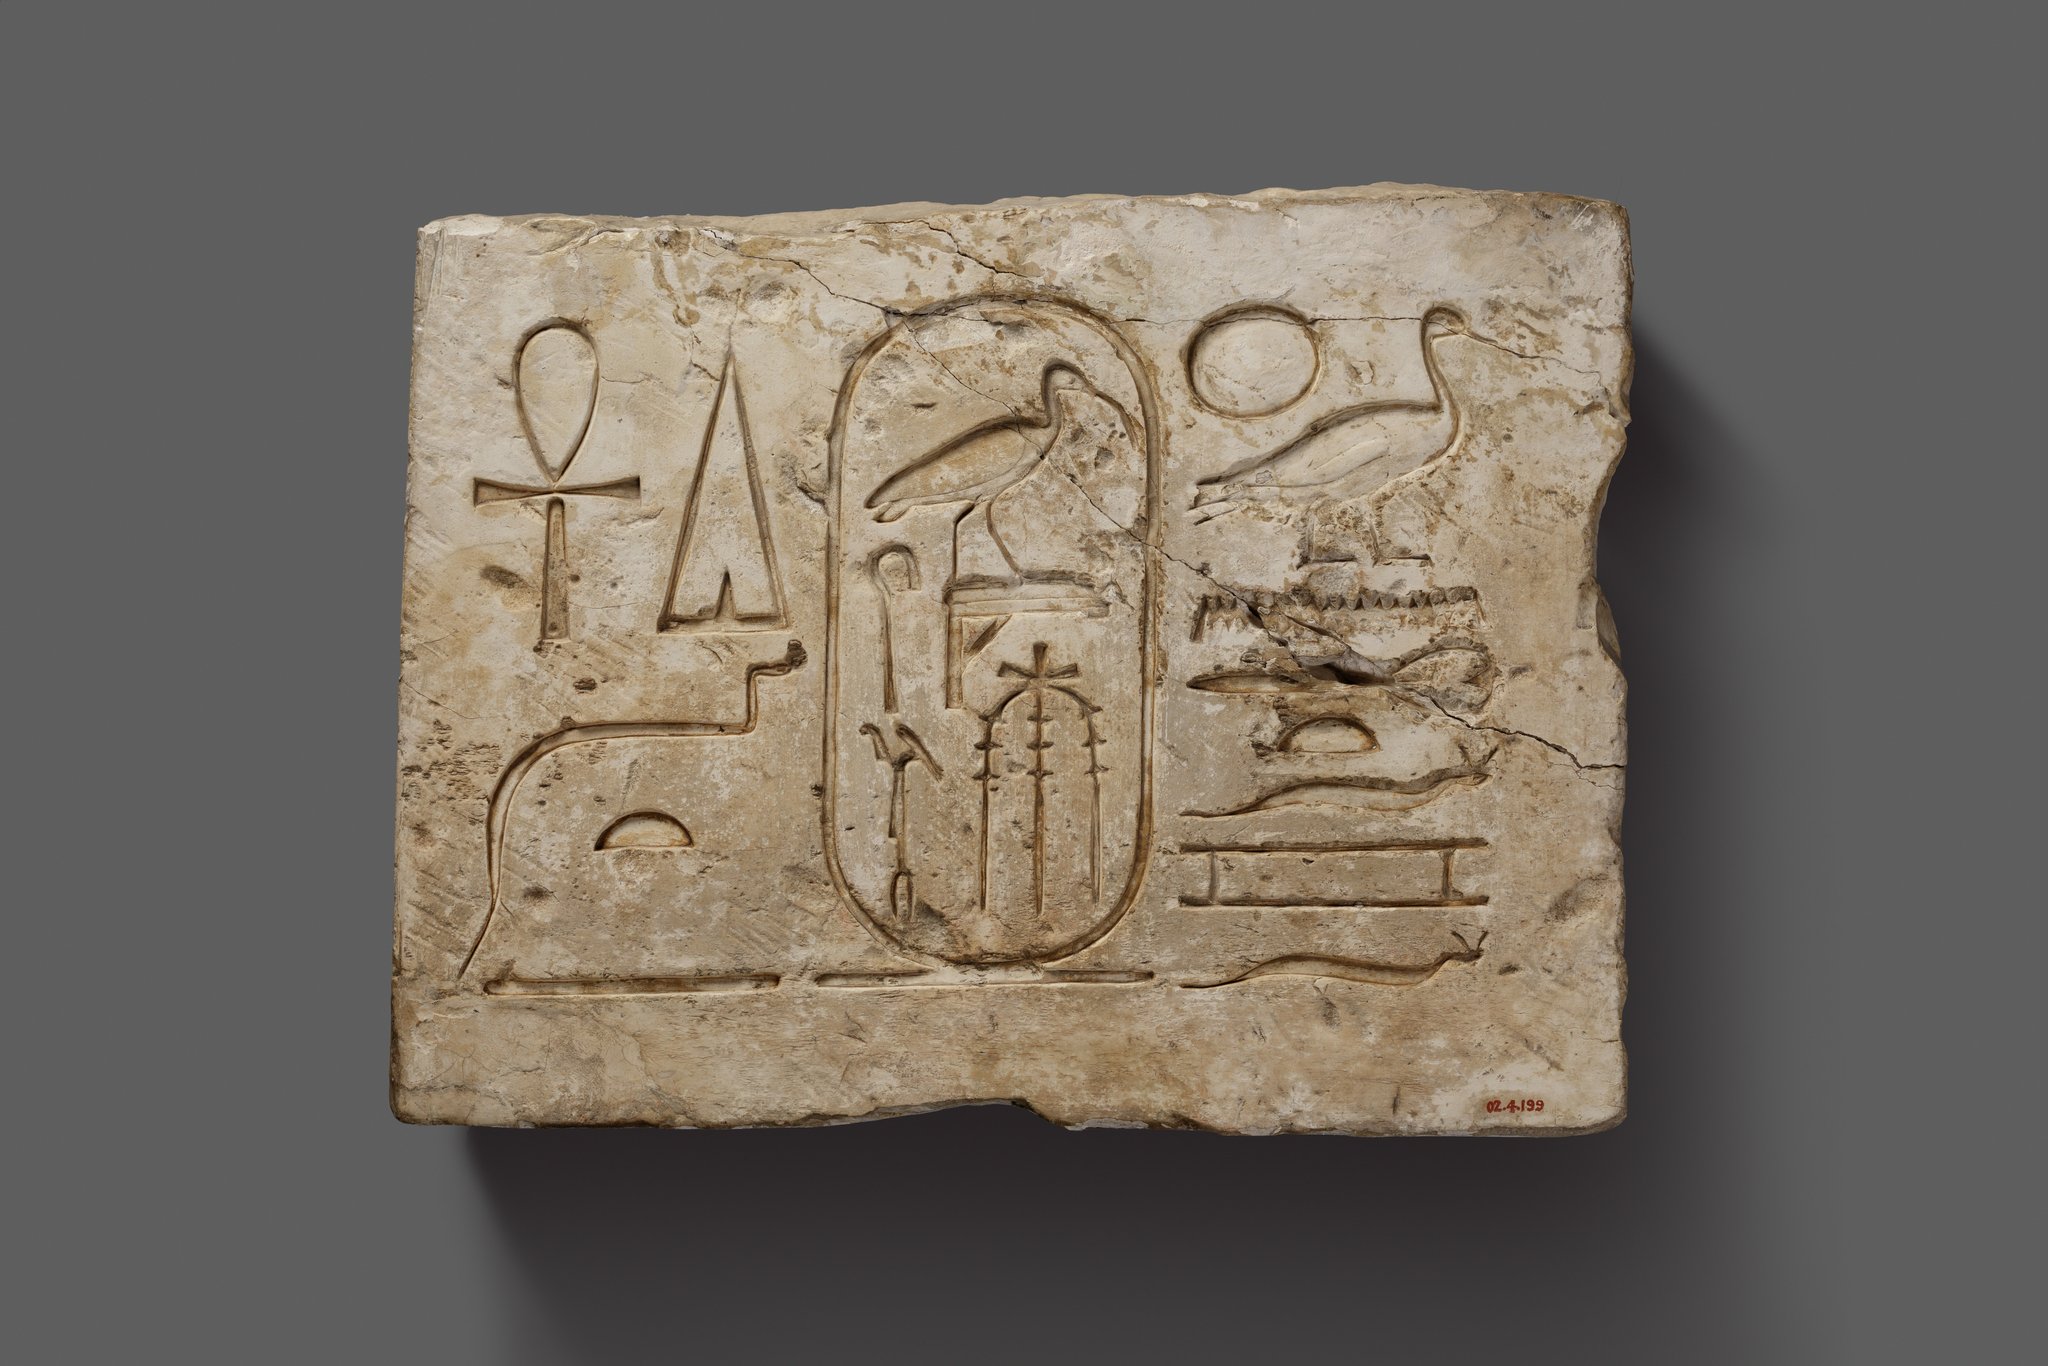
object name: relief, thutmose iii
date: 1550-1295 BCE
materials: limestone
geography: egypt